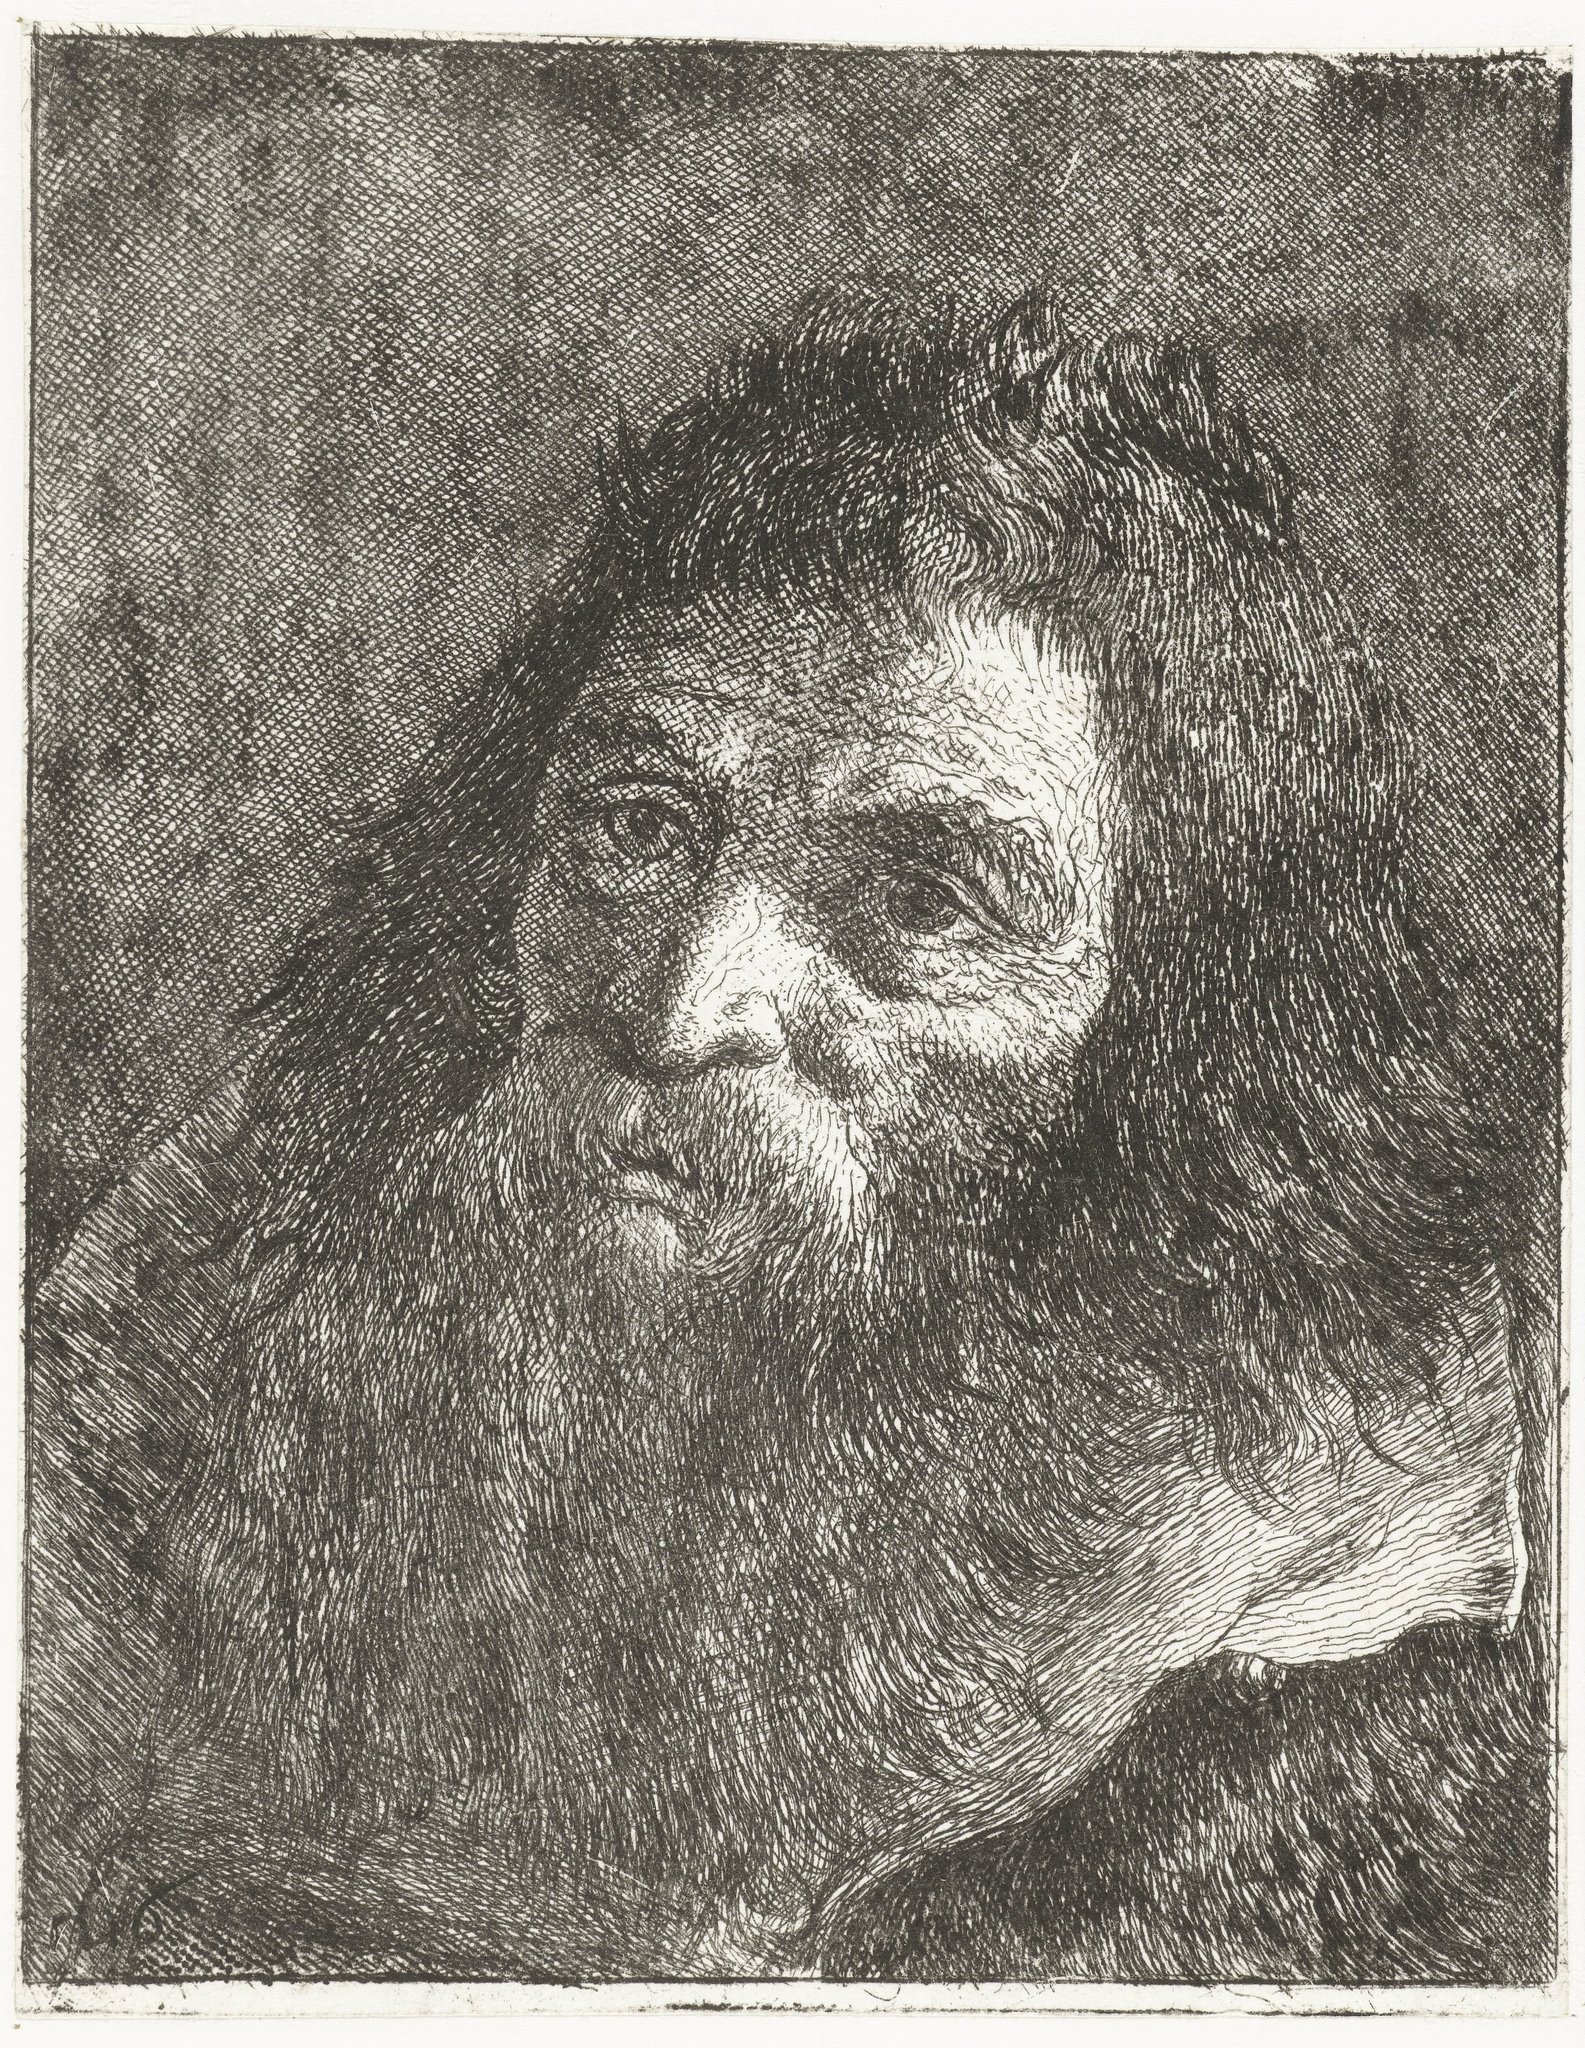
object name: print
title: Man met lang haar en baard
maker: giovanni domenico tiepolo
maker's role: draughtsman, print maker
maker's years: 1727-1804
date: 1757-1758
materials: paper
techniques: etching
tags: person with big beard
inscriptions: collector's mark: Lugt 2228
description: Prent uit serie Verzameling hoofden (Raccolta di teste). Giovanni Domenico Tiepolo vervaardigde in de winter van 1757-1758 en in de periode van 1771-1774 deze hoofden naar schilderijen en tekeningen van Giovanni Battista Tiepolo. De eerste uitgave verscheen in 1774 in twee delen met elk dertig prenten. Deze prent werd in de tweede staat met serienummer 26 opgenomen in deel 2.